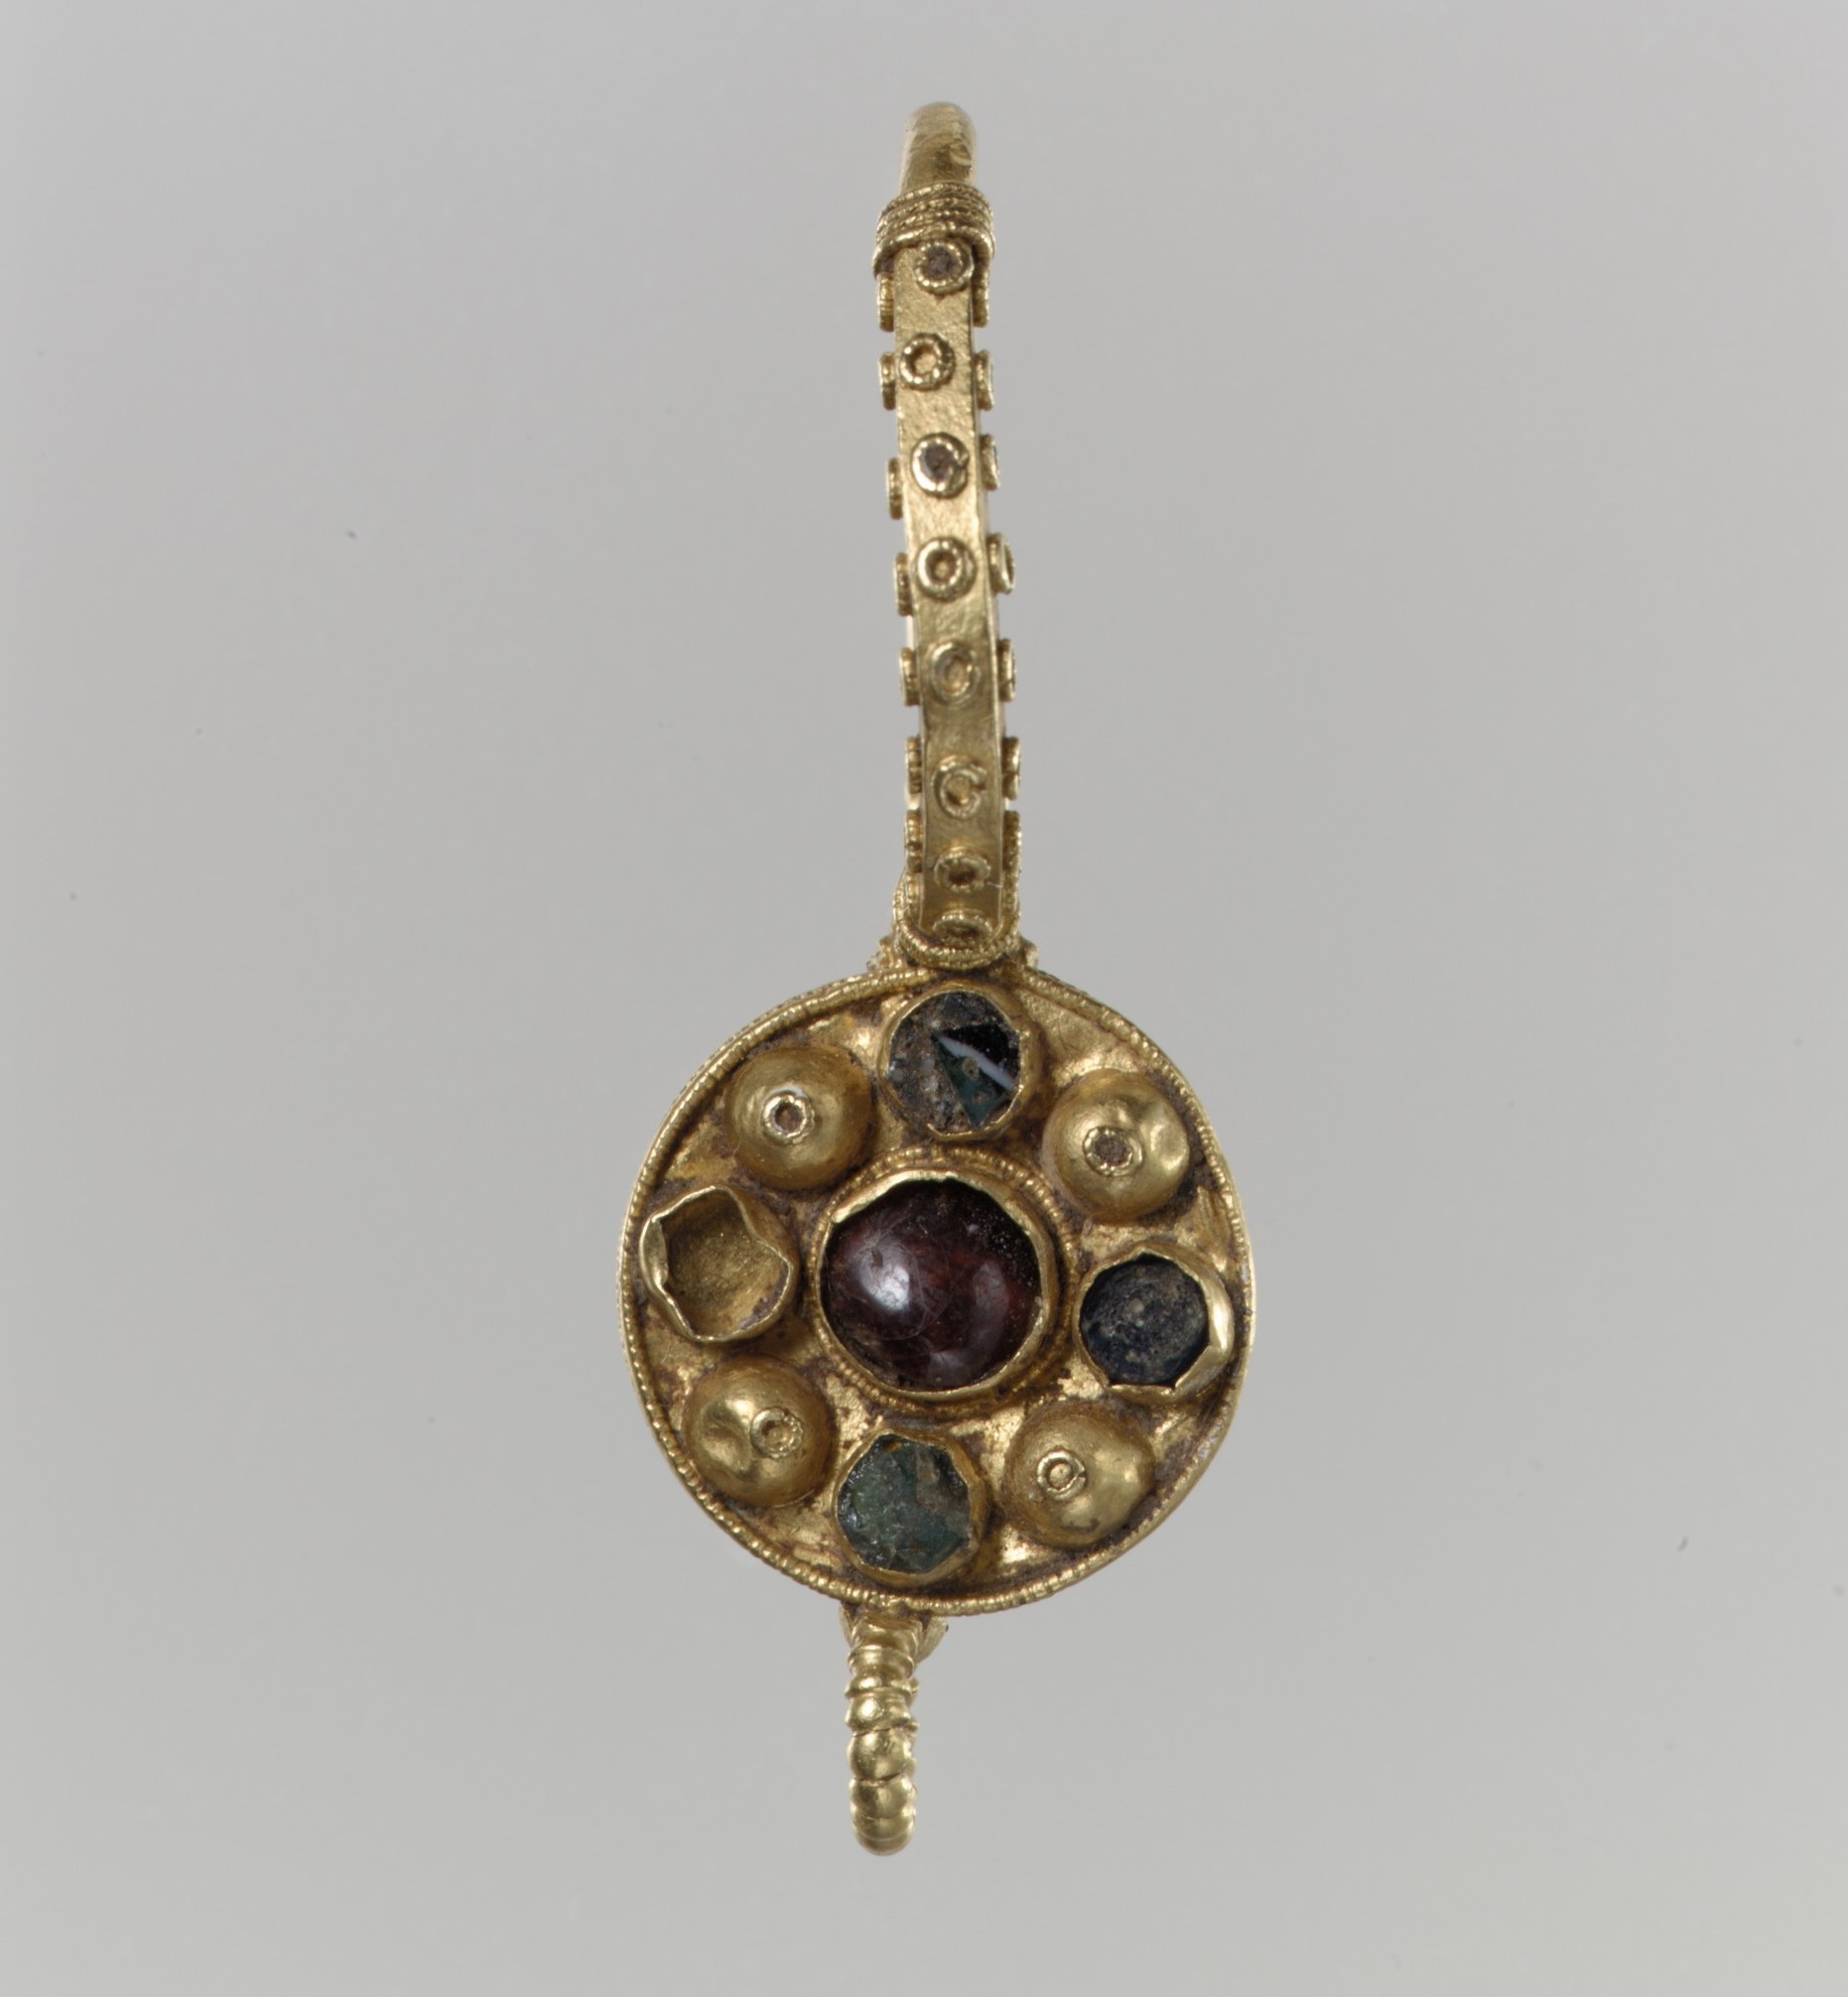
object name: earring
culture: byzantine or langobardic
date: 501-700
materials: gemstone, glass, gold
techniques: inlay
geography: italy